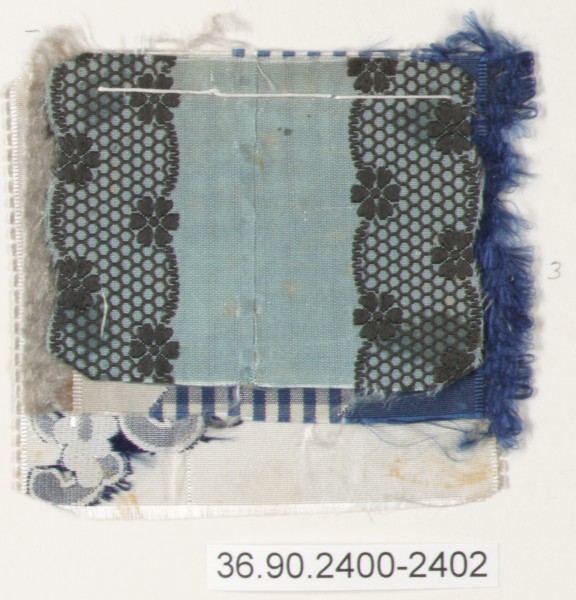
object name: ribbon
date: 1801-1900